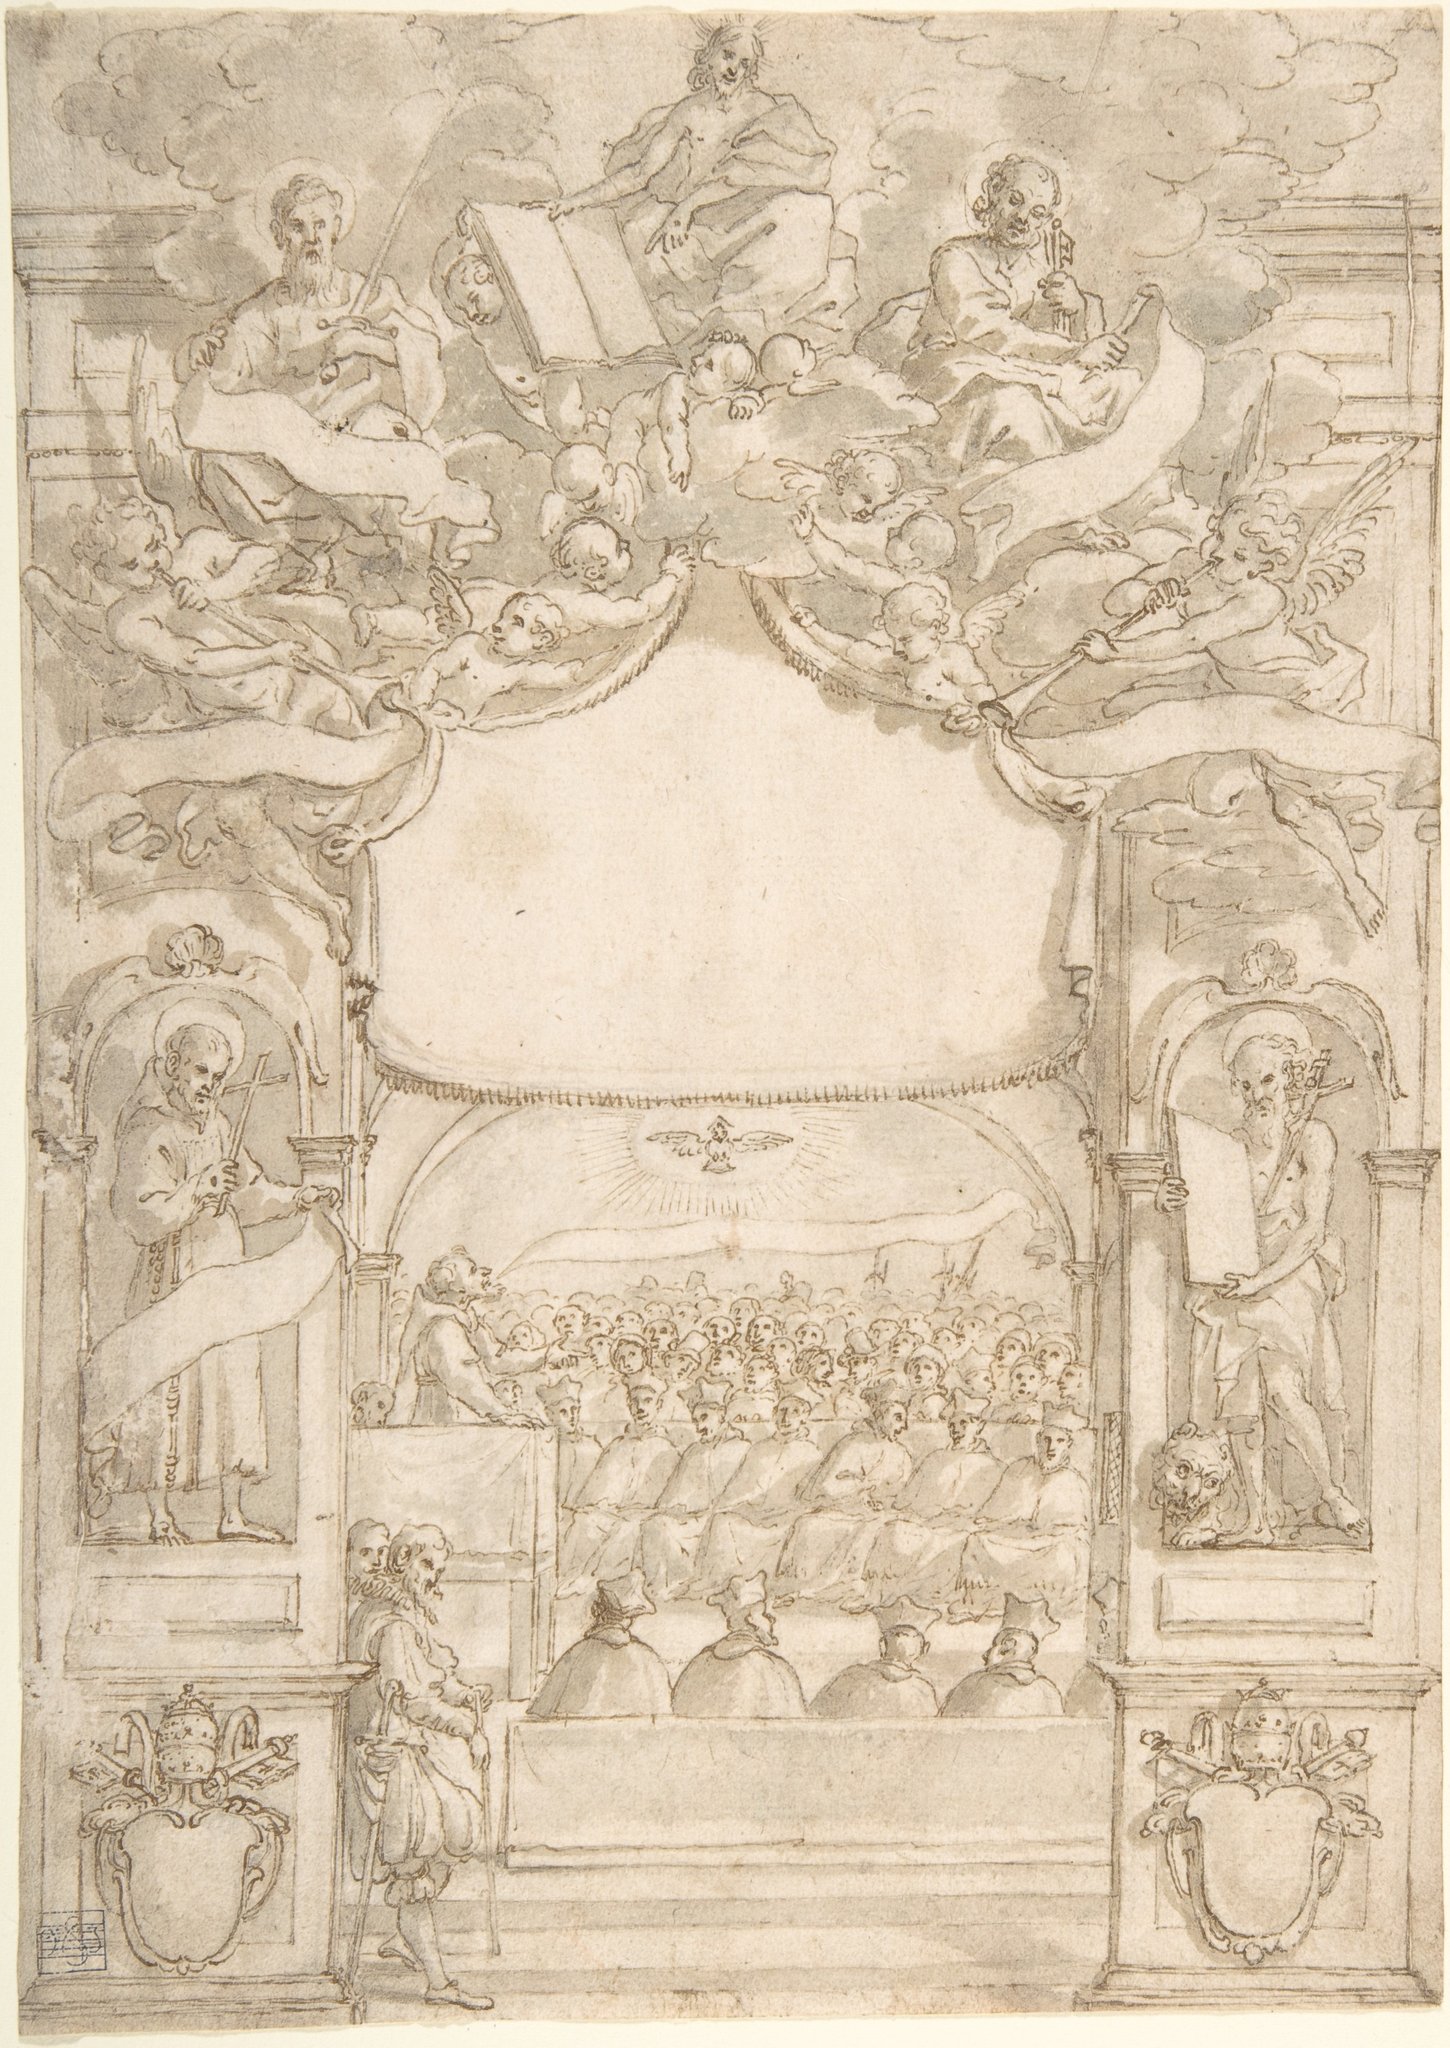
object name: drawing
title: Design for a Title Page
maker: anonymous, italian, late 16th century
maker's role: artist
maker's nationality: italian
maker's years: 1550-1600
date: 1567-1600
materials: ink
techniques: brush, pen, wash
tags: men,women,cross,coat of arms